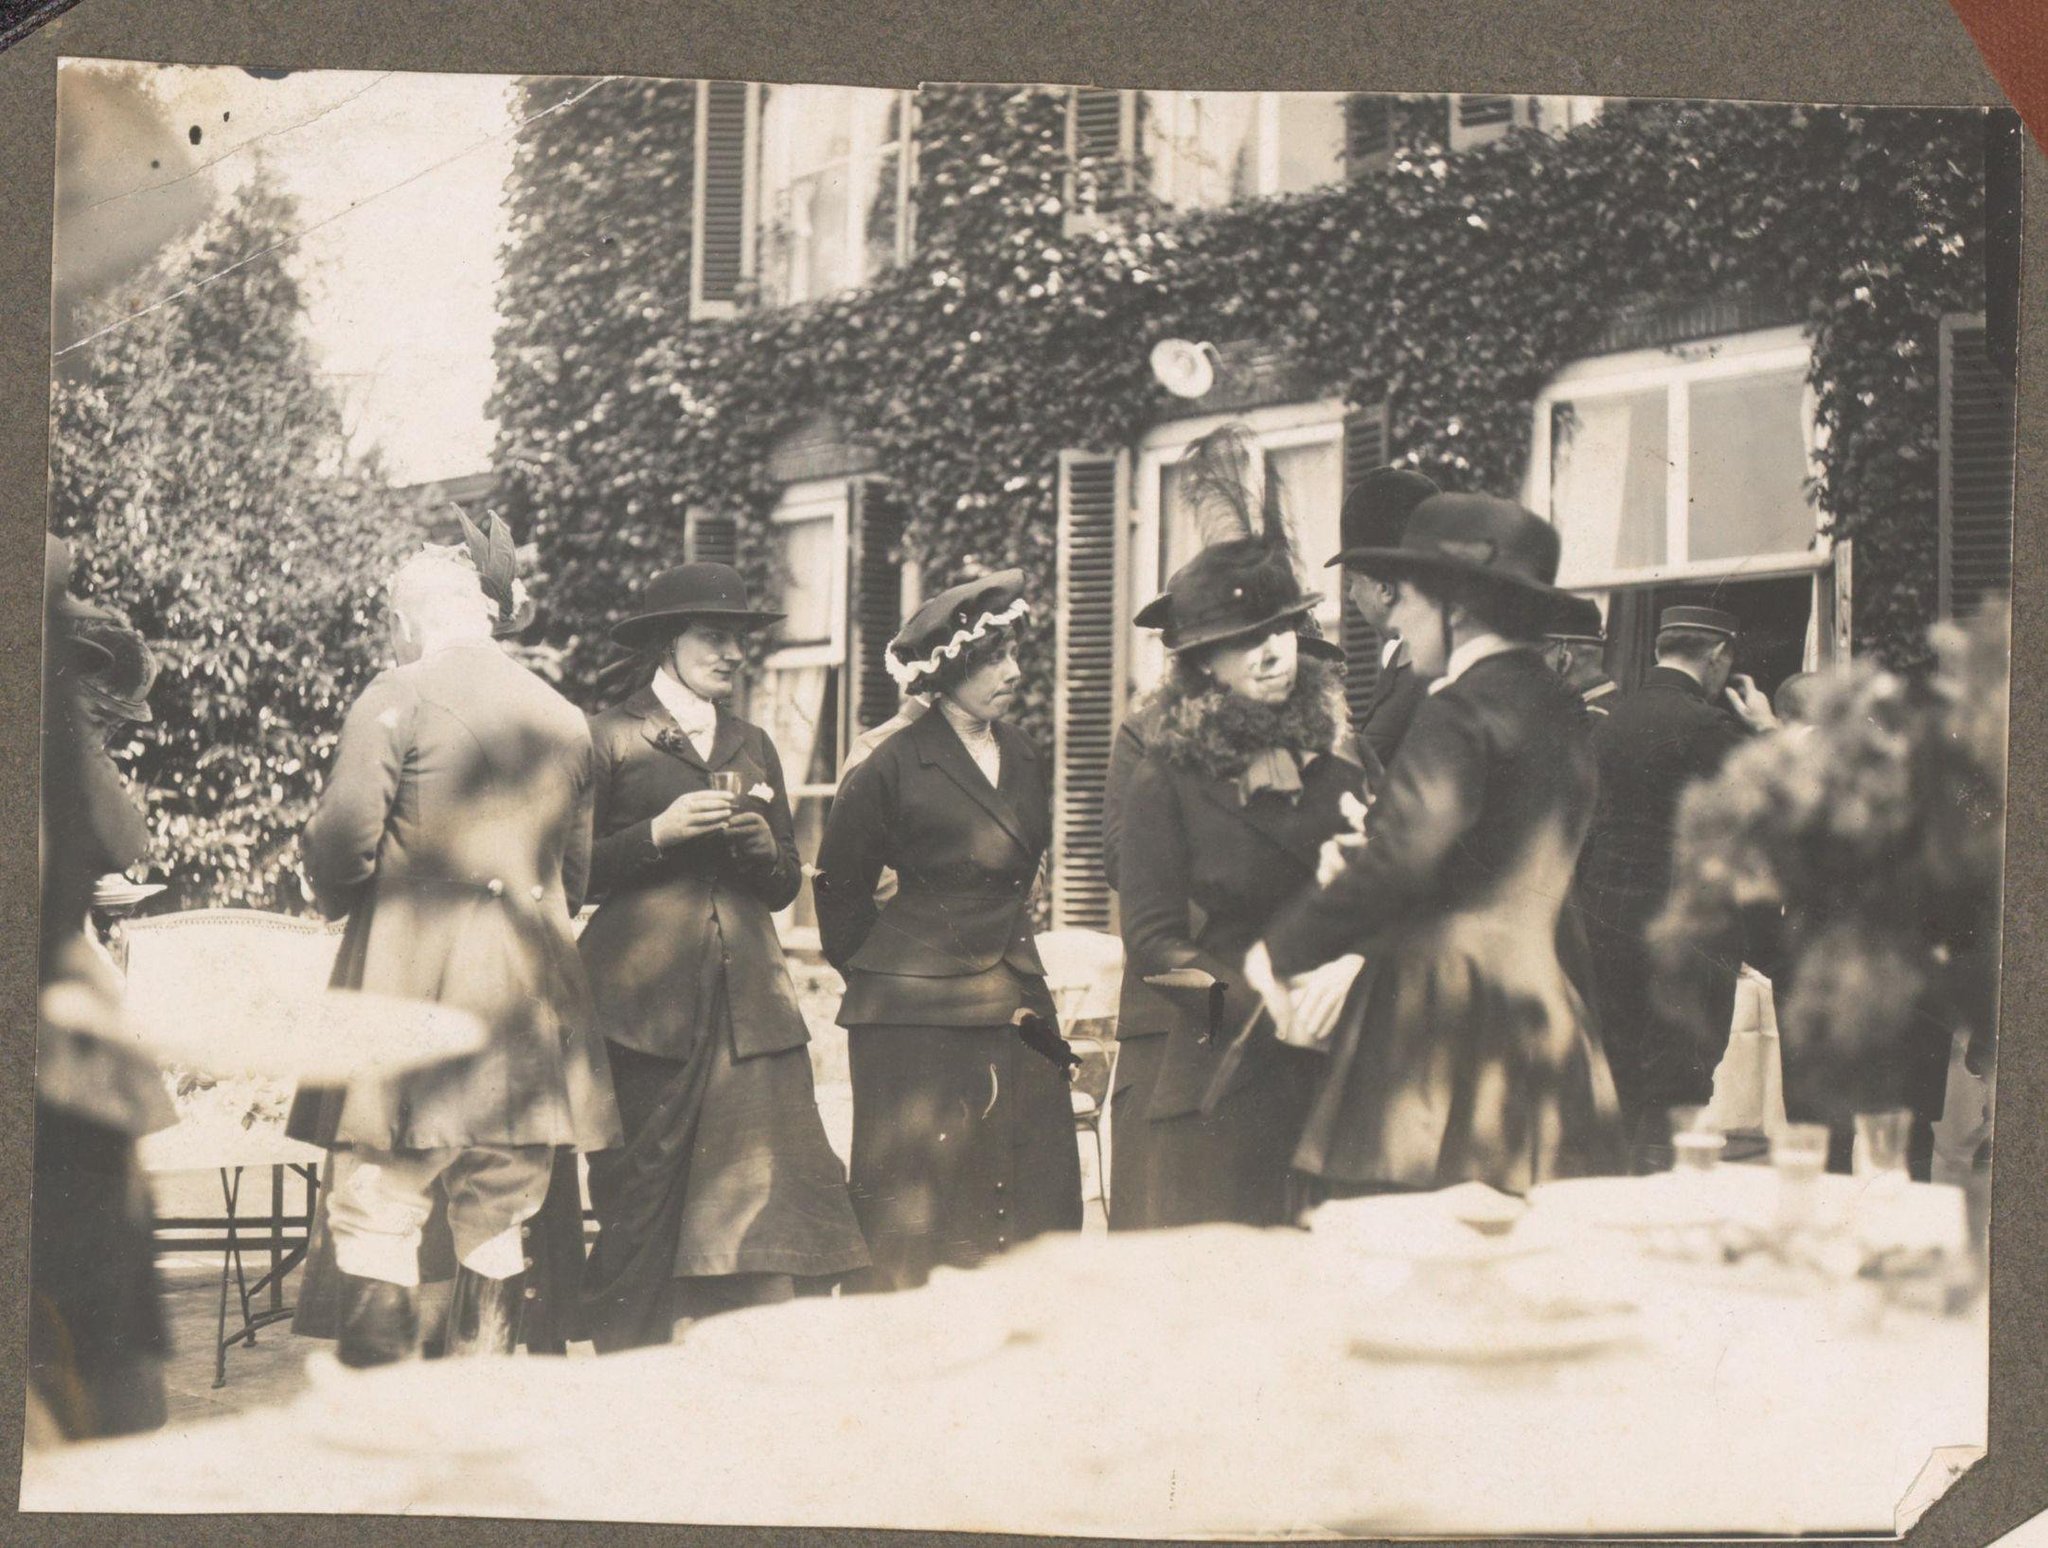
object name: photograph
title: Ruitertafereel op Koninklijke Houtvesterij Het Loo: vrouwen bij gedekte tafels bij een landhuis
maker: Anonymous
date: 1900-1925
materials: photographic support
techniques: gelatin silver print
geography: het loo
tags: hunting, chase, hunting-ground, rural housing, e.g. country-house, villa, cottage, eating and drinking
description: Onderdeel van Fotoalbum van de heer Brams, opperhoutvester van koningin Wilhelmina op Koninklijke Houtvesterij Het Loo.